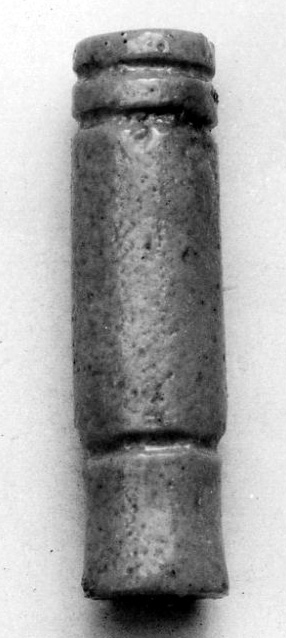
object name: kohl tube, incised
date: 332-330 BCE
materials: faience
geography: egypt